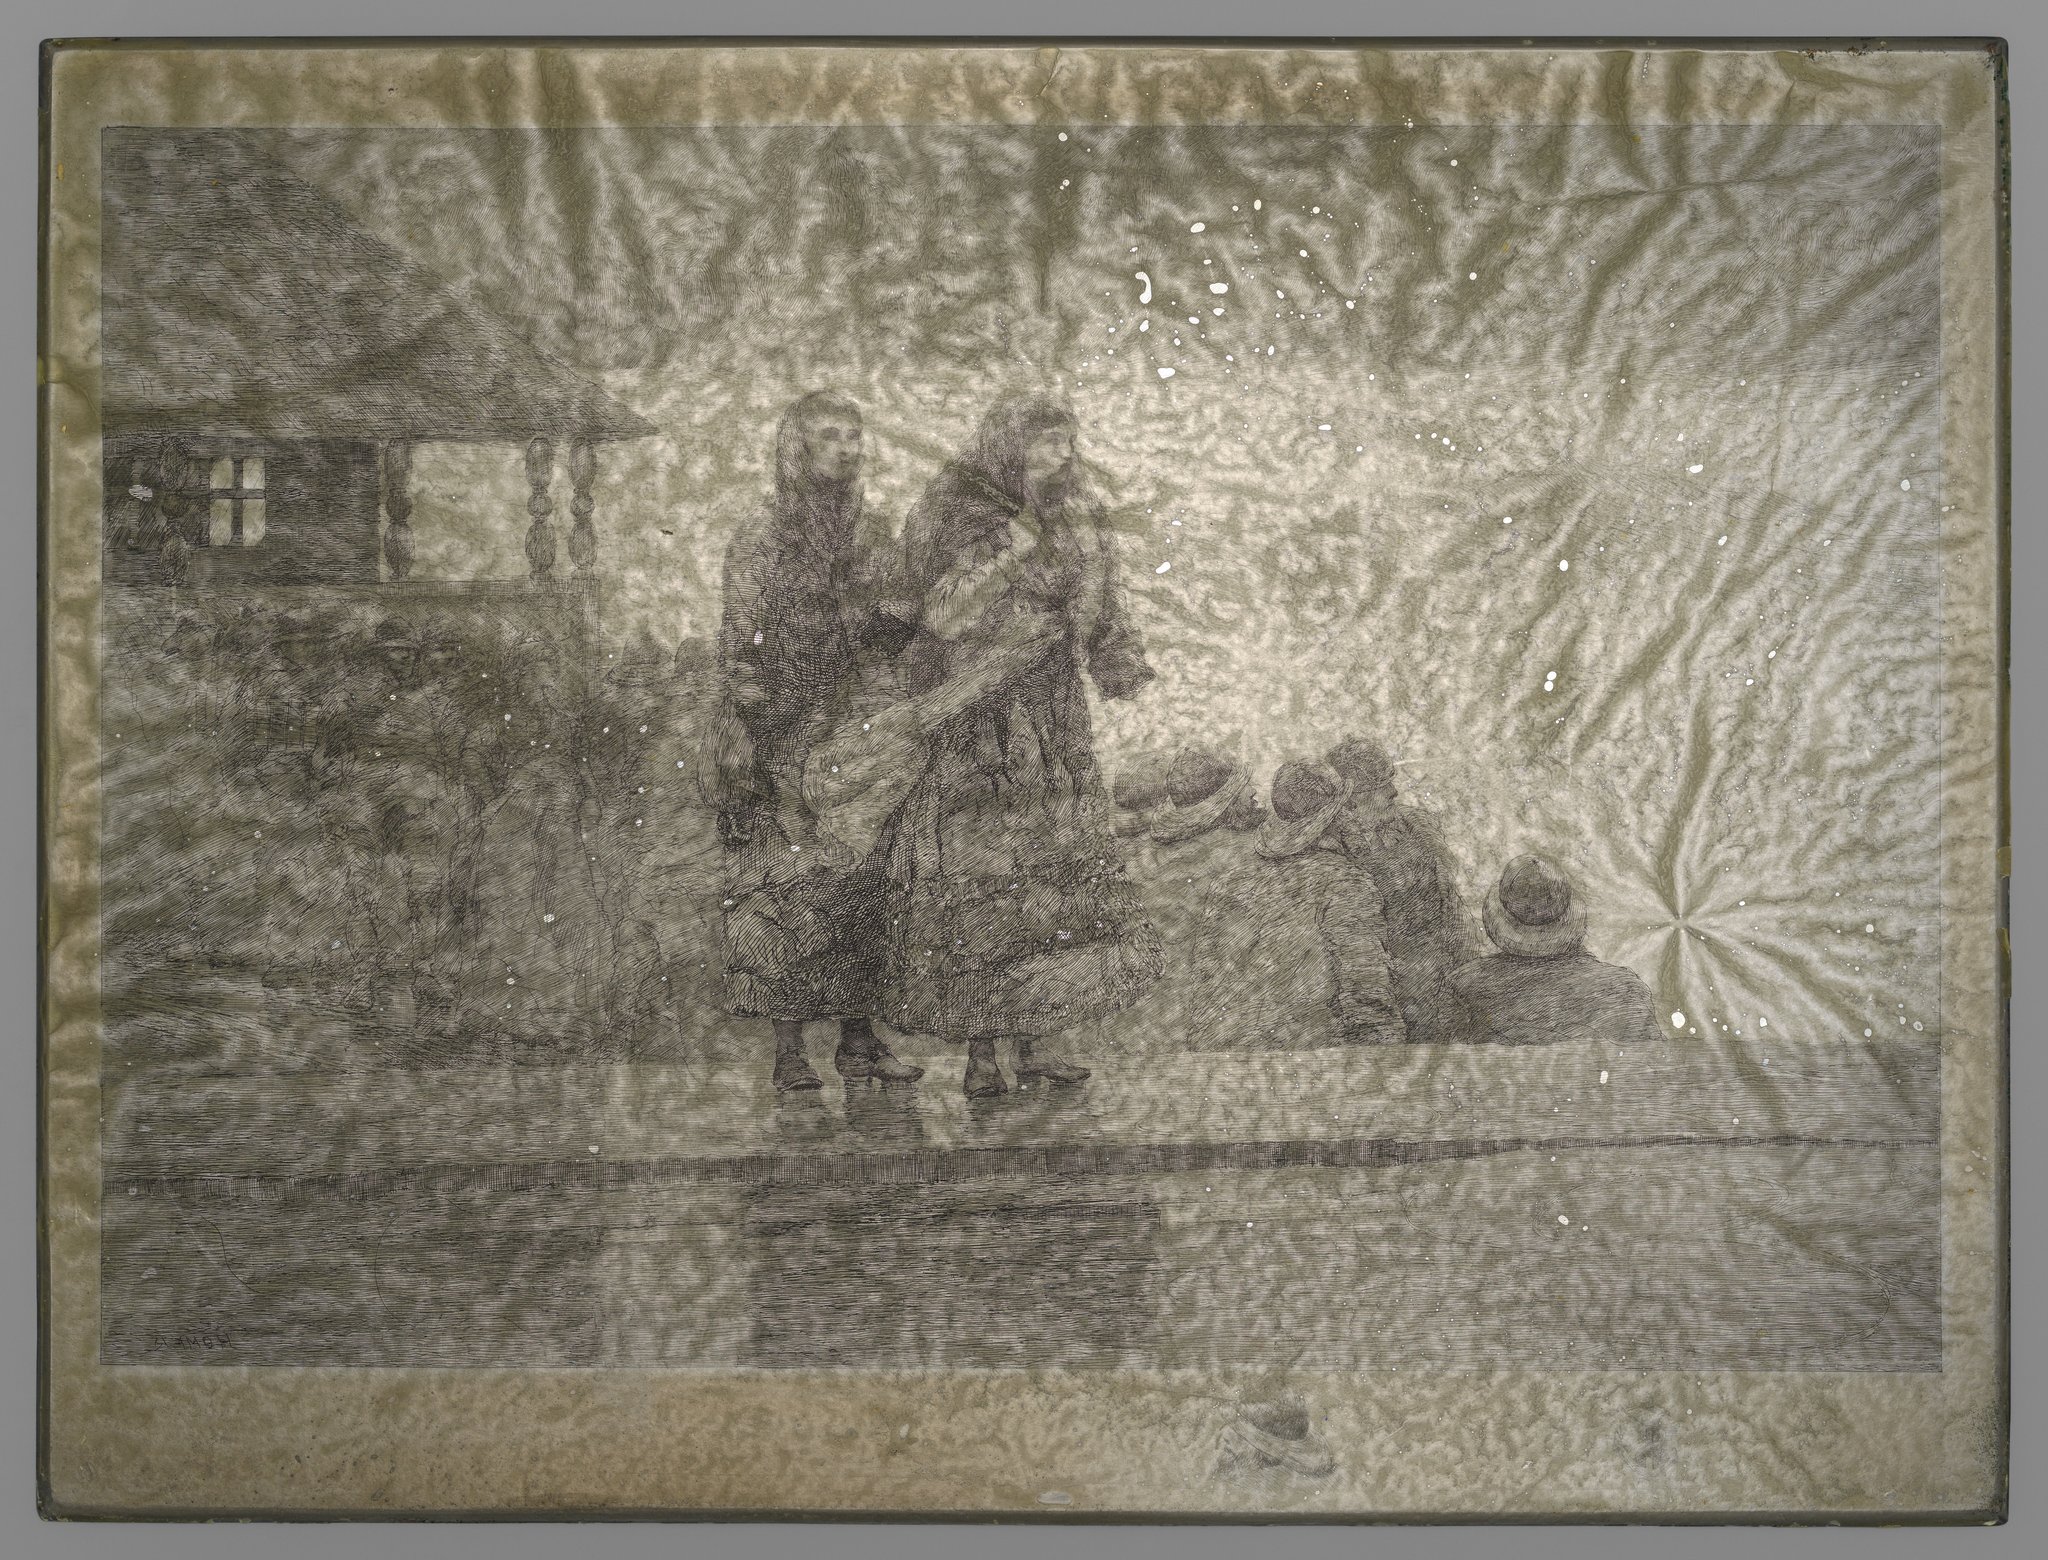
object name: plate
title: Perils of the Sea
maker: winslow homer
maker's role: artist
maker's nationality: american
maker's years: 1836-1910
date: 1888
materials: copper, steel